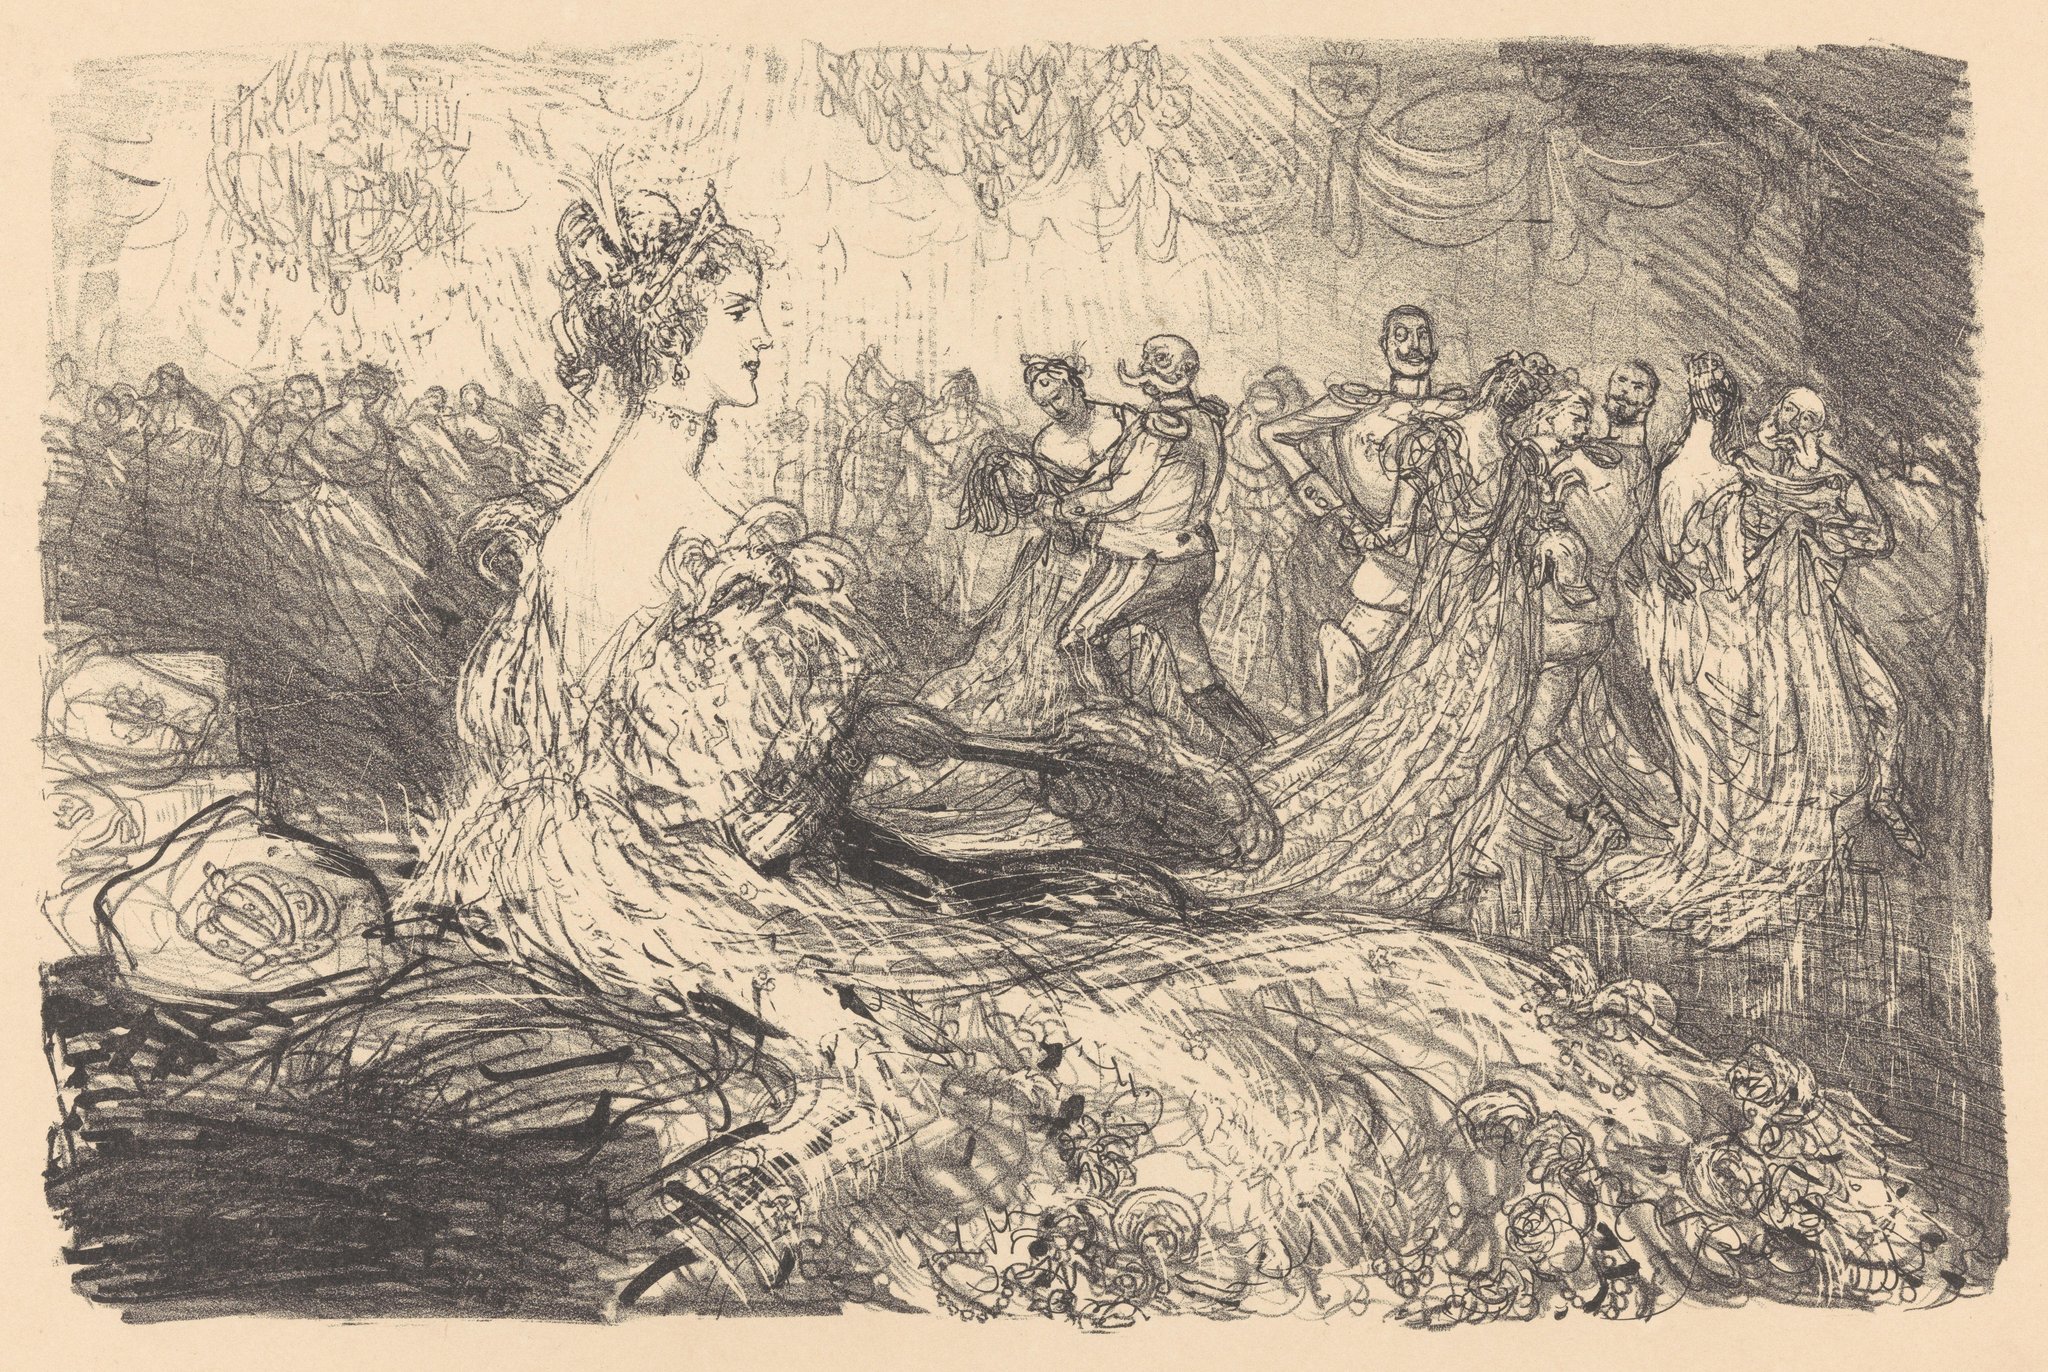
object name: print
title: Alleen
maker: marius bauer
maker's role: draughtsman, print maker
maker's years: 1867-1932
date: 1896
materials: paper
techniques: lithograph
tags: victoria (koningin van het verenigd koninkrijk en keizerin van india), political caricatures and satires, great britain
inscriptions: collector's mark: Lugt 2228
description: Spotprent op Engelands Splendid Isolation. Koningin Victoria alleen aan de kant zittend terwijl de andere Europese vorsten op de dansvloer dansen. Verschenen in het bijvoegsel van 'De Kroniek' van 22 maart 1896.